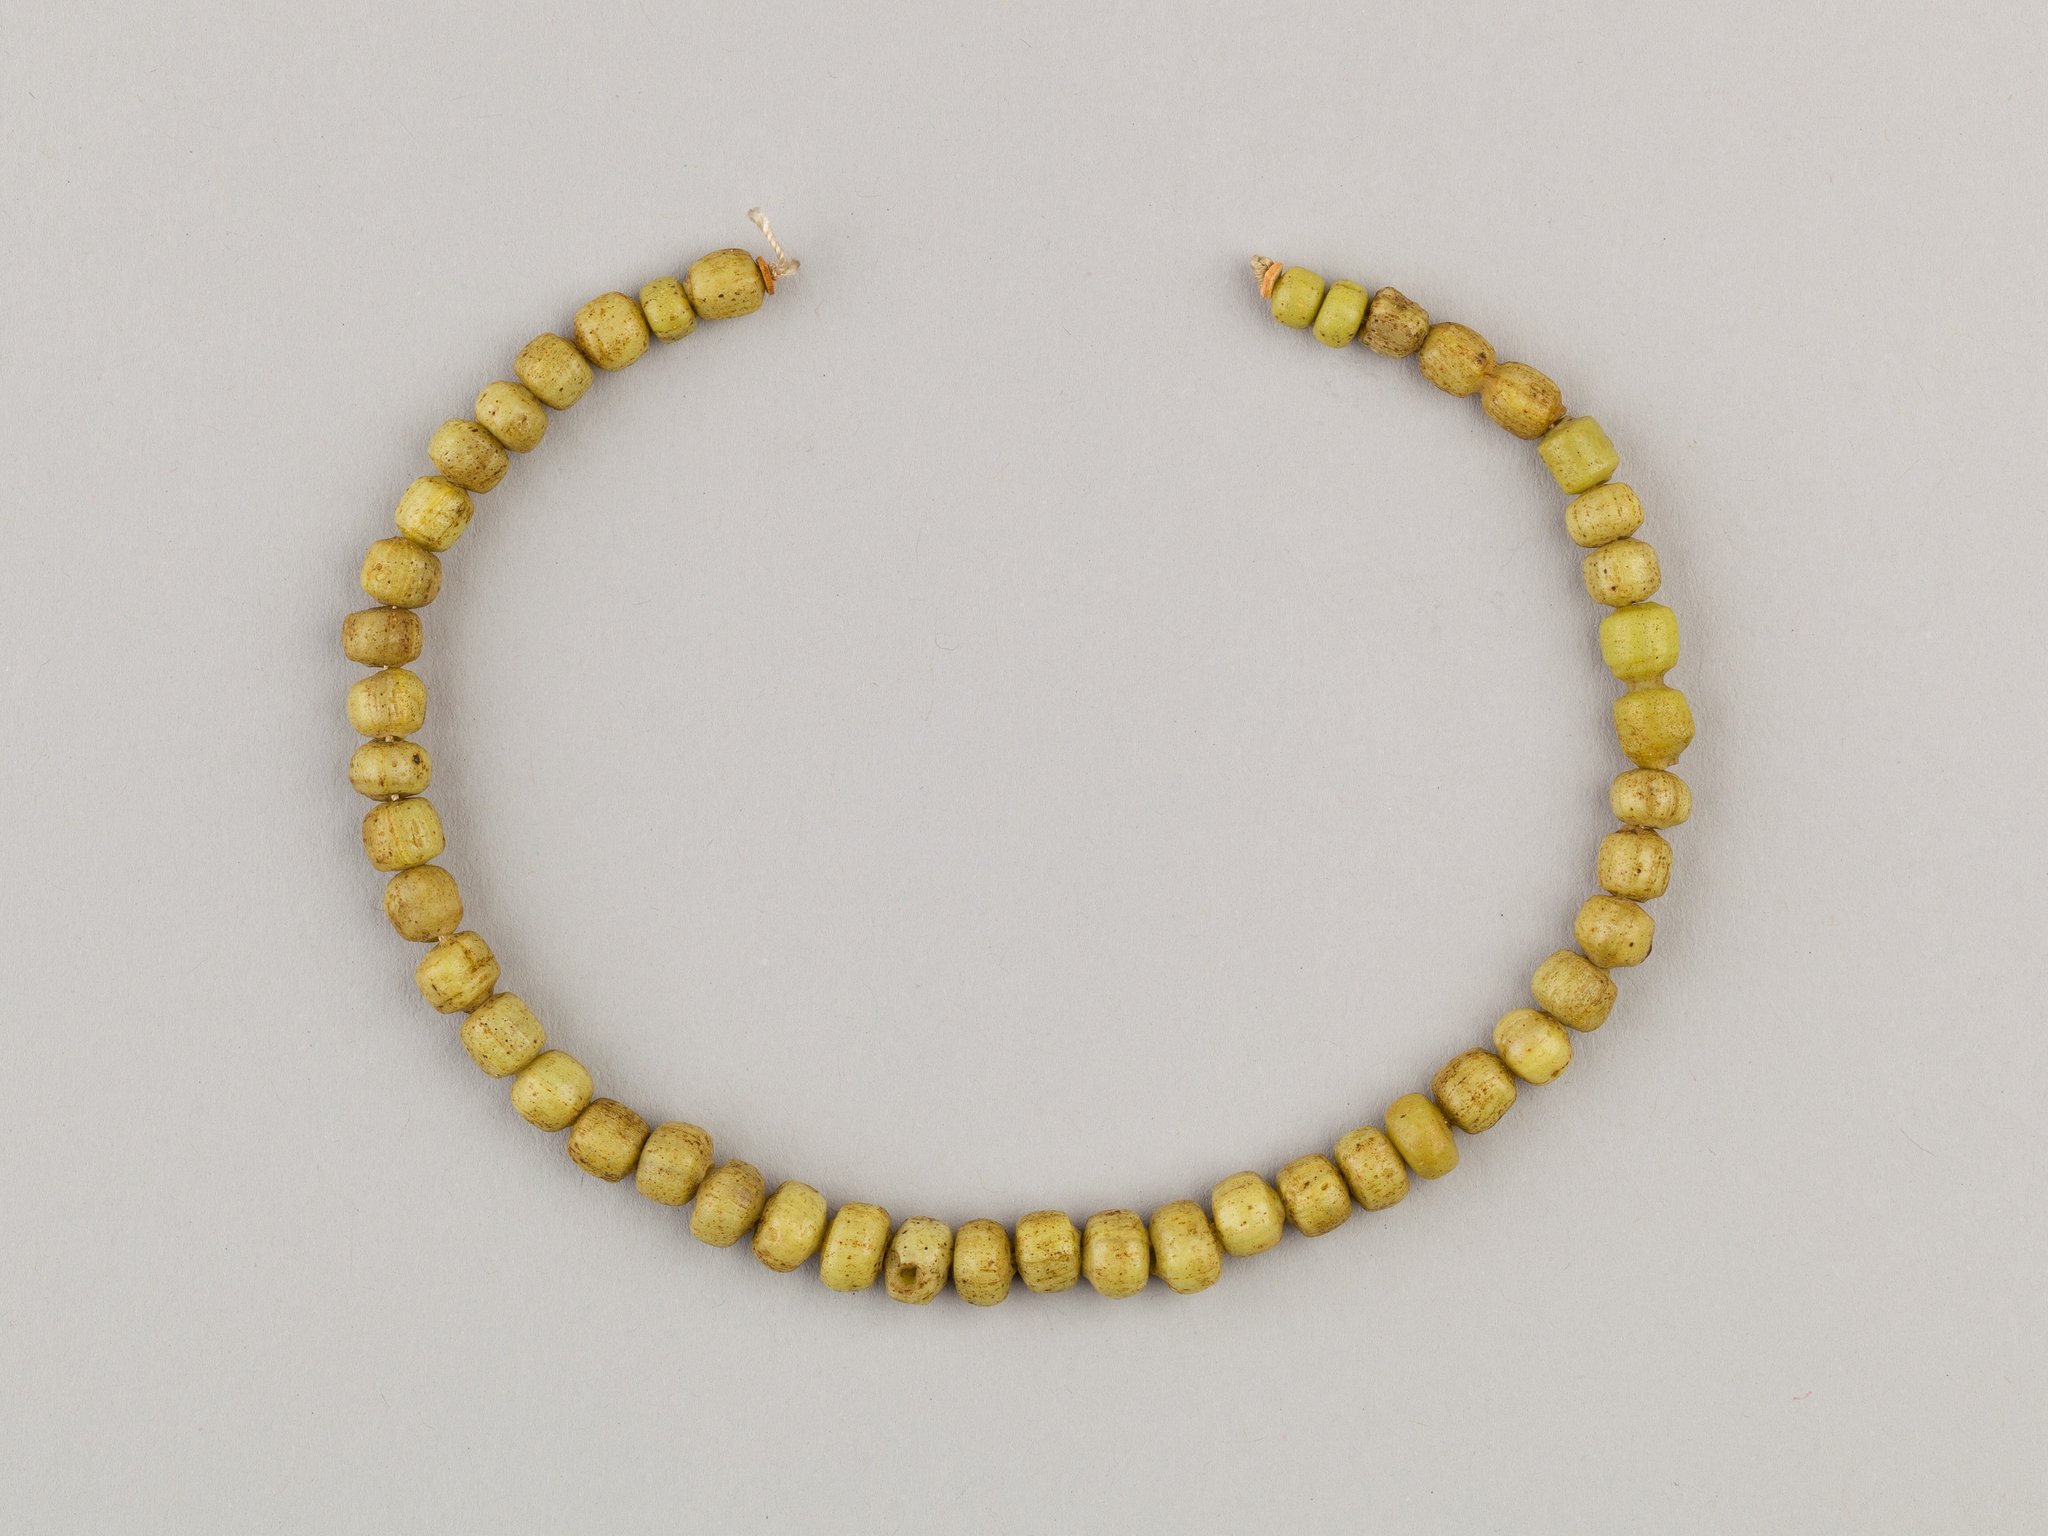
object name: bead, string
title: String of 46 disc beads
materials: glass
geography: egypt